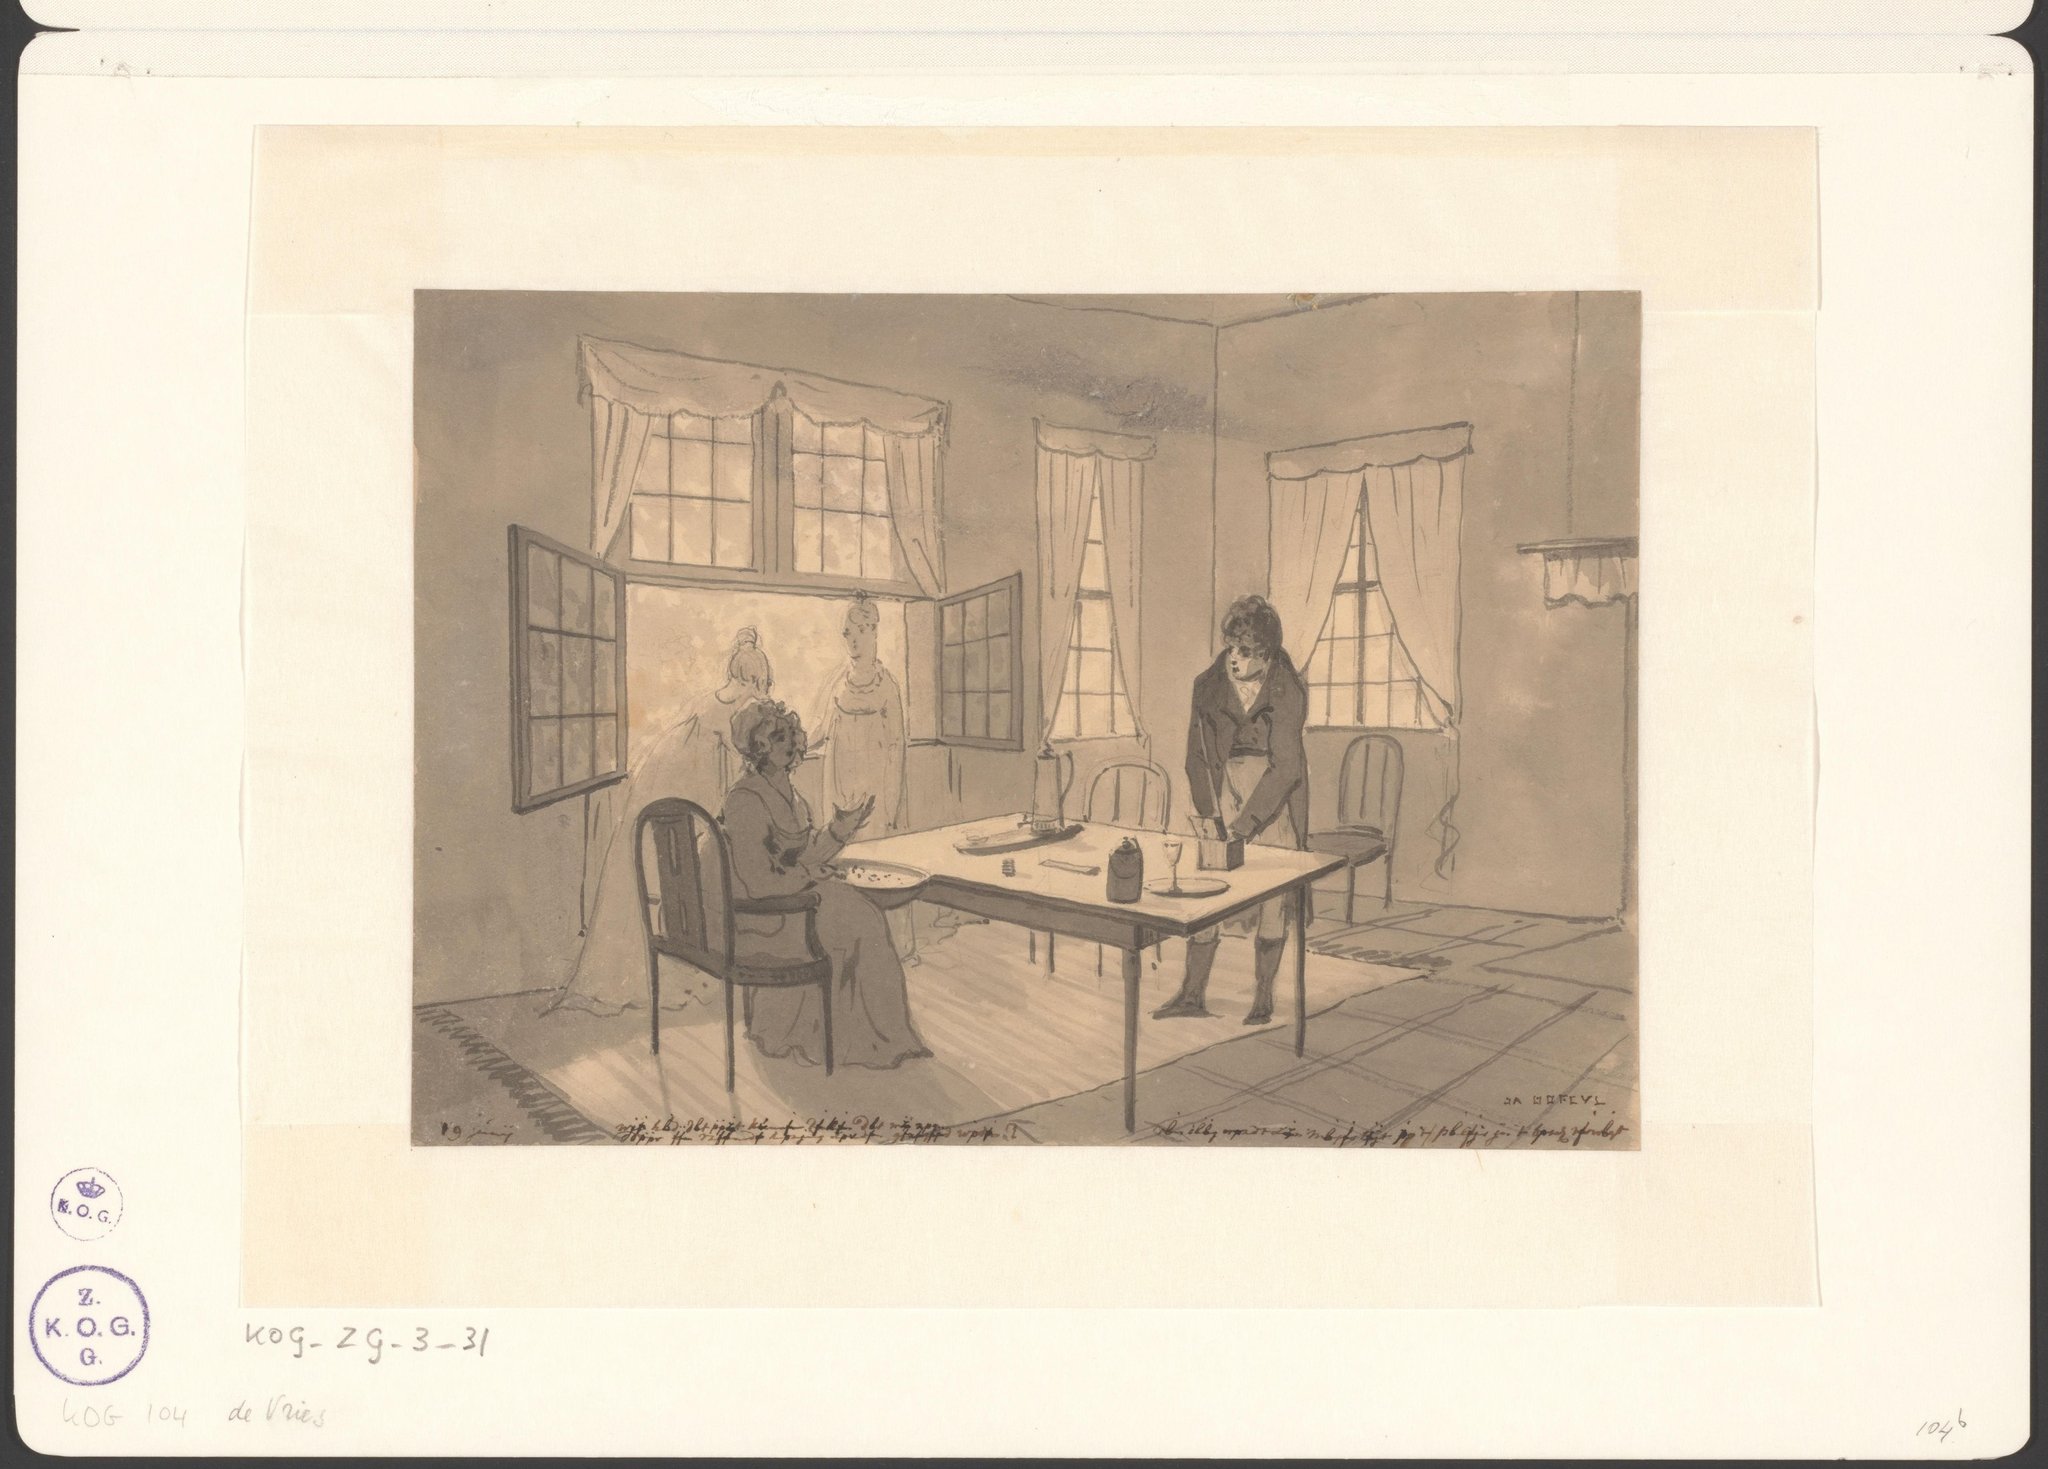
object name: drawing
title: Interieur met Christiaan Andriessen en drie dames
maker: christiaan andriessen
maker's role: draughtsman, print maker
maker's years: 1775-1846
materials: ink, paper, pencil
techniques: brush, pen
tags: living-room, parlour, sitting-room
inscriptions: inscription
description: Dagboekblad uit het getekende dagboek dat Christiaan Andriessen bijhield van 1805 tot en met 1808.